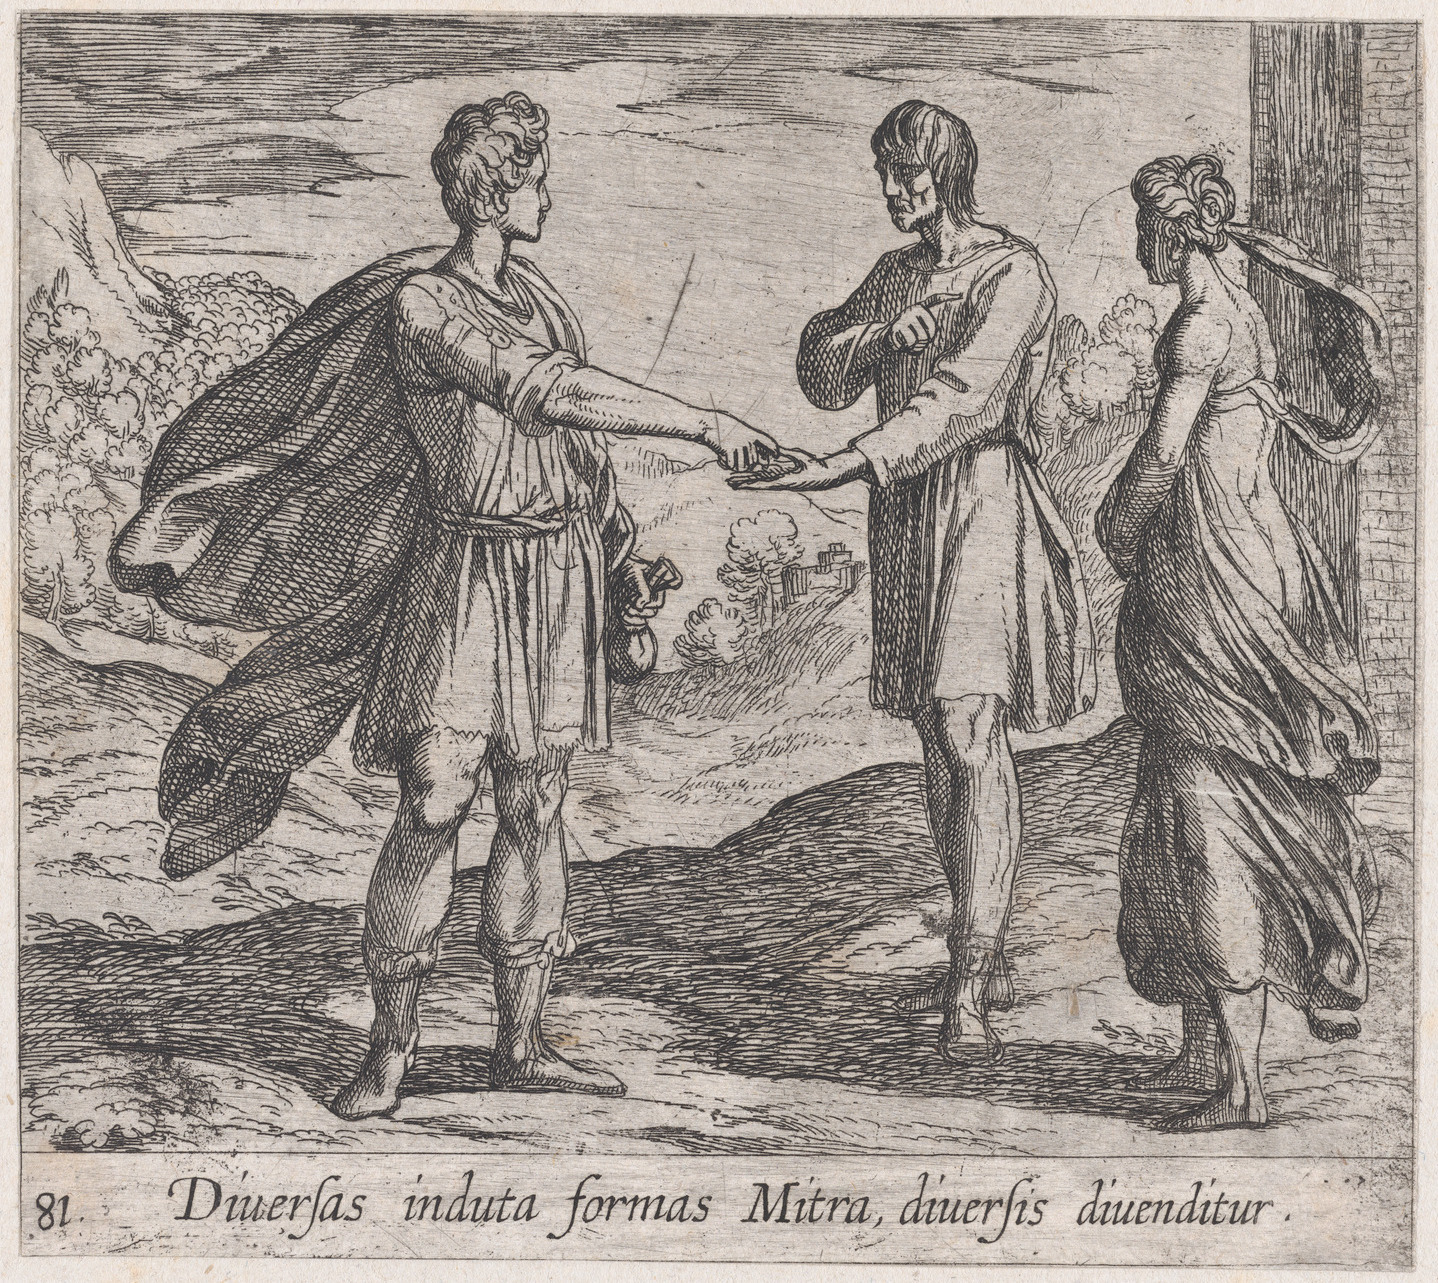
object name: print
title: Plate 81: Erysichthon Selling his Daughter (Diversas induta Mitra diversis divenditur), from Ovid's 'Metamorphoses'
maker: antonio tempesta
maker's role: artist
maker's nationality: italian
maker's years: 1555-1630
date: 1606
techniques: etching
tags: men,women